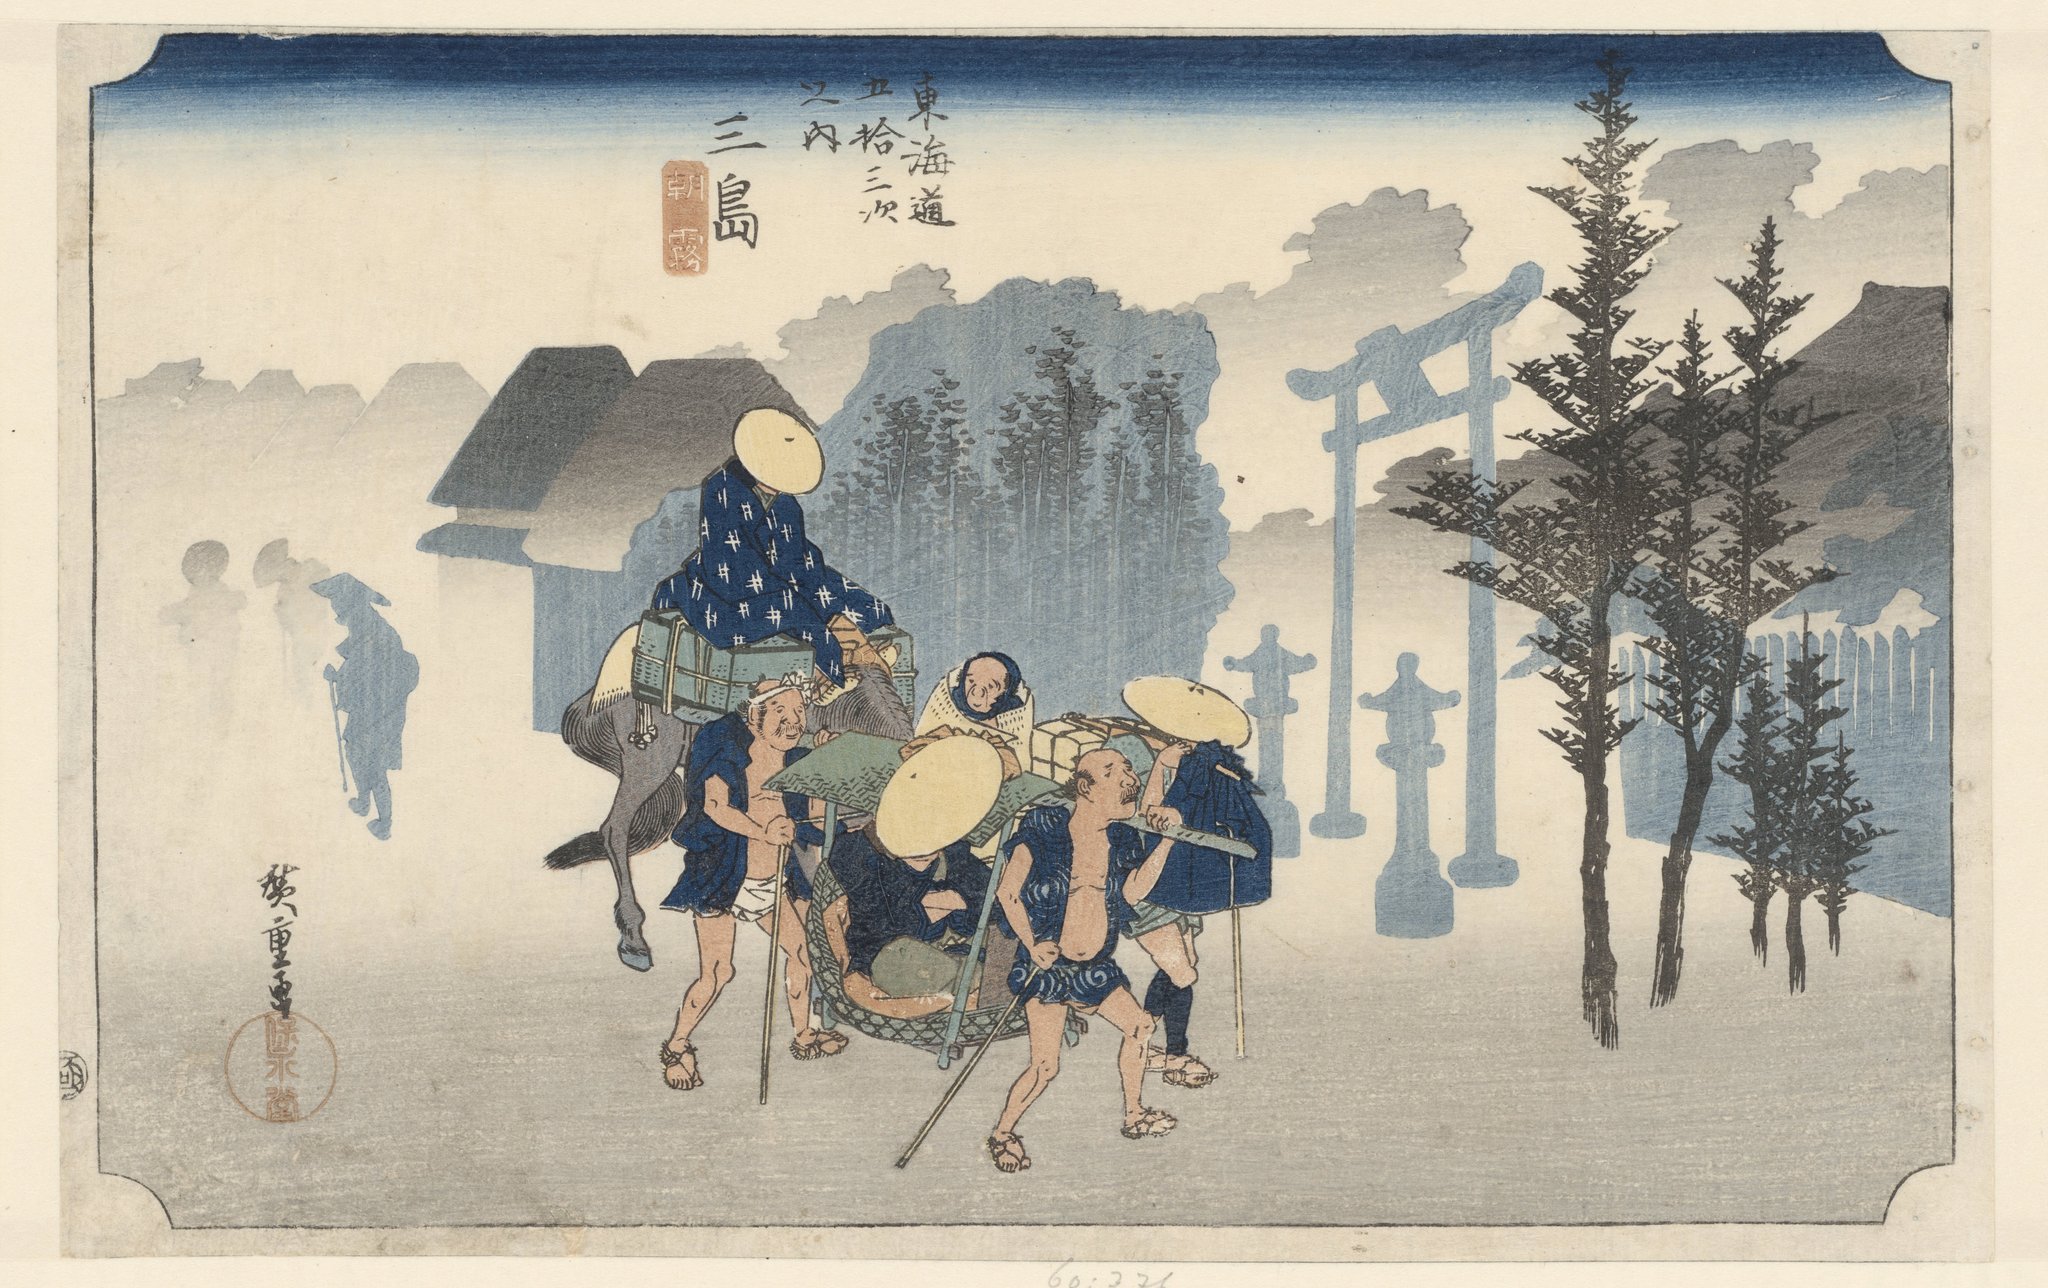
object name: print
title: Tokaido gojusan tsugi no uchi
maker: utagawa hiroshige (i)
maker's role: draughtsman, print maker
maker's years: 1797-1858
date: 1828-1835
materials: paper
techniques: woodcut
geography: tokyo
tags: (carrying a person in a) sedan-chair, temple, shrine ~ non-christian religions, mist, fog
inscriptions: collector's mark: Lugt 2228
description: Reizigers in een draagstoel en op een paard s`ochtend vroeg in het dorp Mishima; op de achtergrond de omtrekken van een torii (toegangspoort naar een Shinto heiligdom).